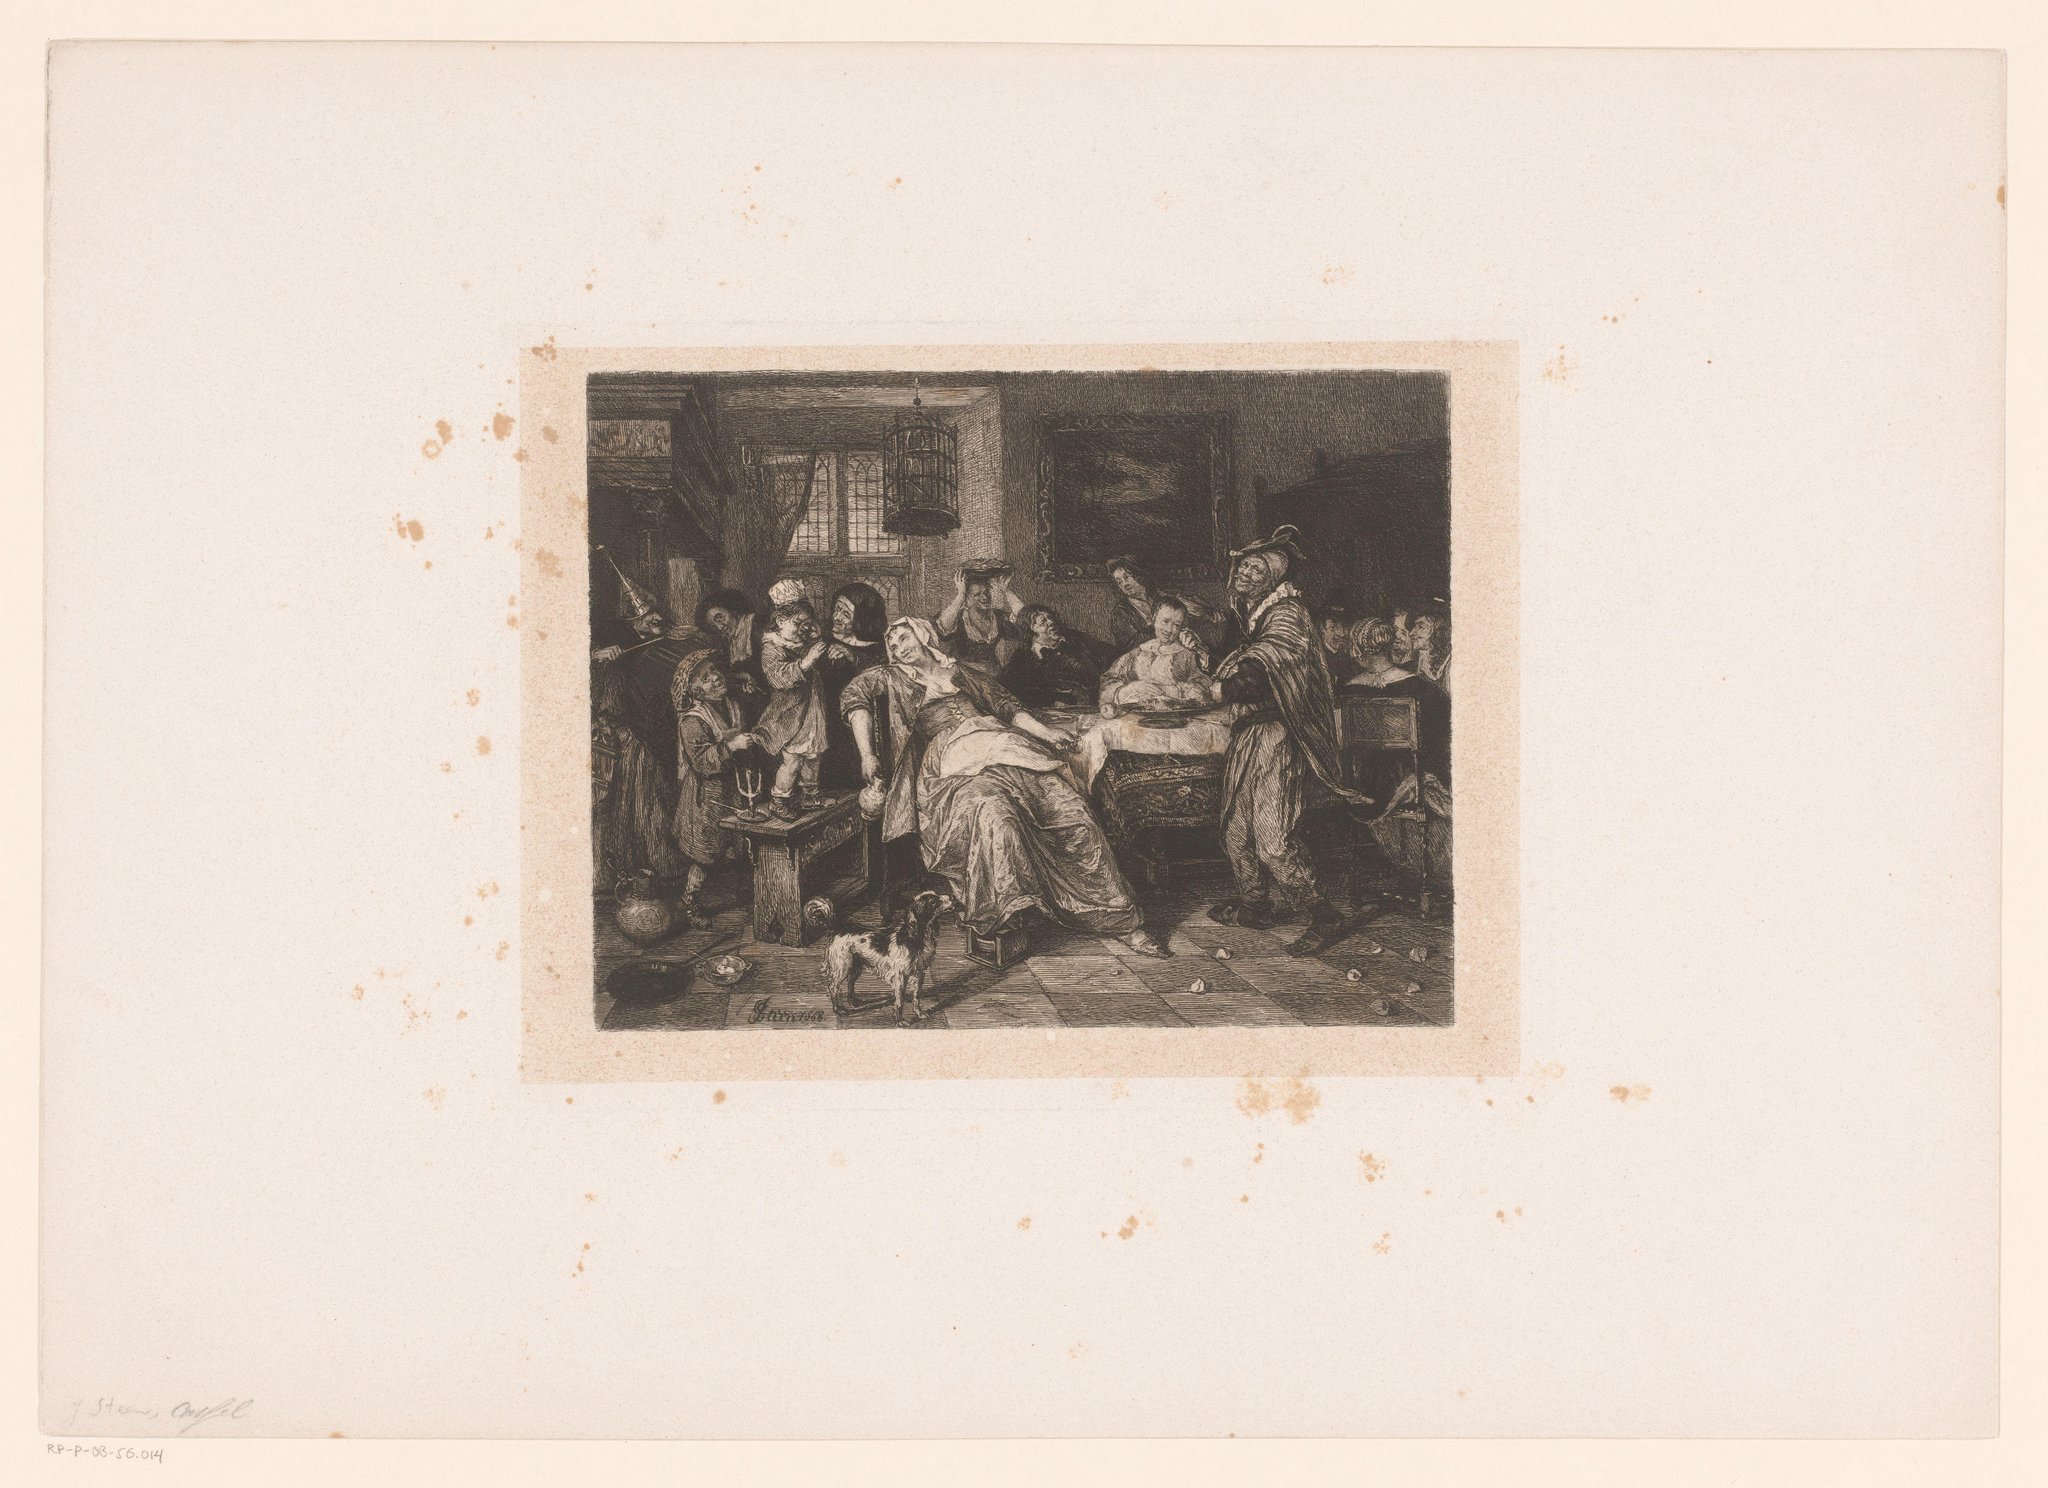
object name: print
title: Driekoningenfeest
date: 1847-1889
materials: paper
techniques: etching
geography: germany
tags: empty bird cage, twelfth night, usually falling on the eve of january 6, vocal music, singing, alcoholic drinks, improvised musical instruments: rumbling pot, dog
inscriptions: collector's mark: Lugt 2228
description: Prent naar het schilderij door Jan Havicksz. Steen in de Gemäldegalerie Alte Meister te Kassel (inv.nr. GK 296).